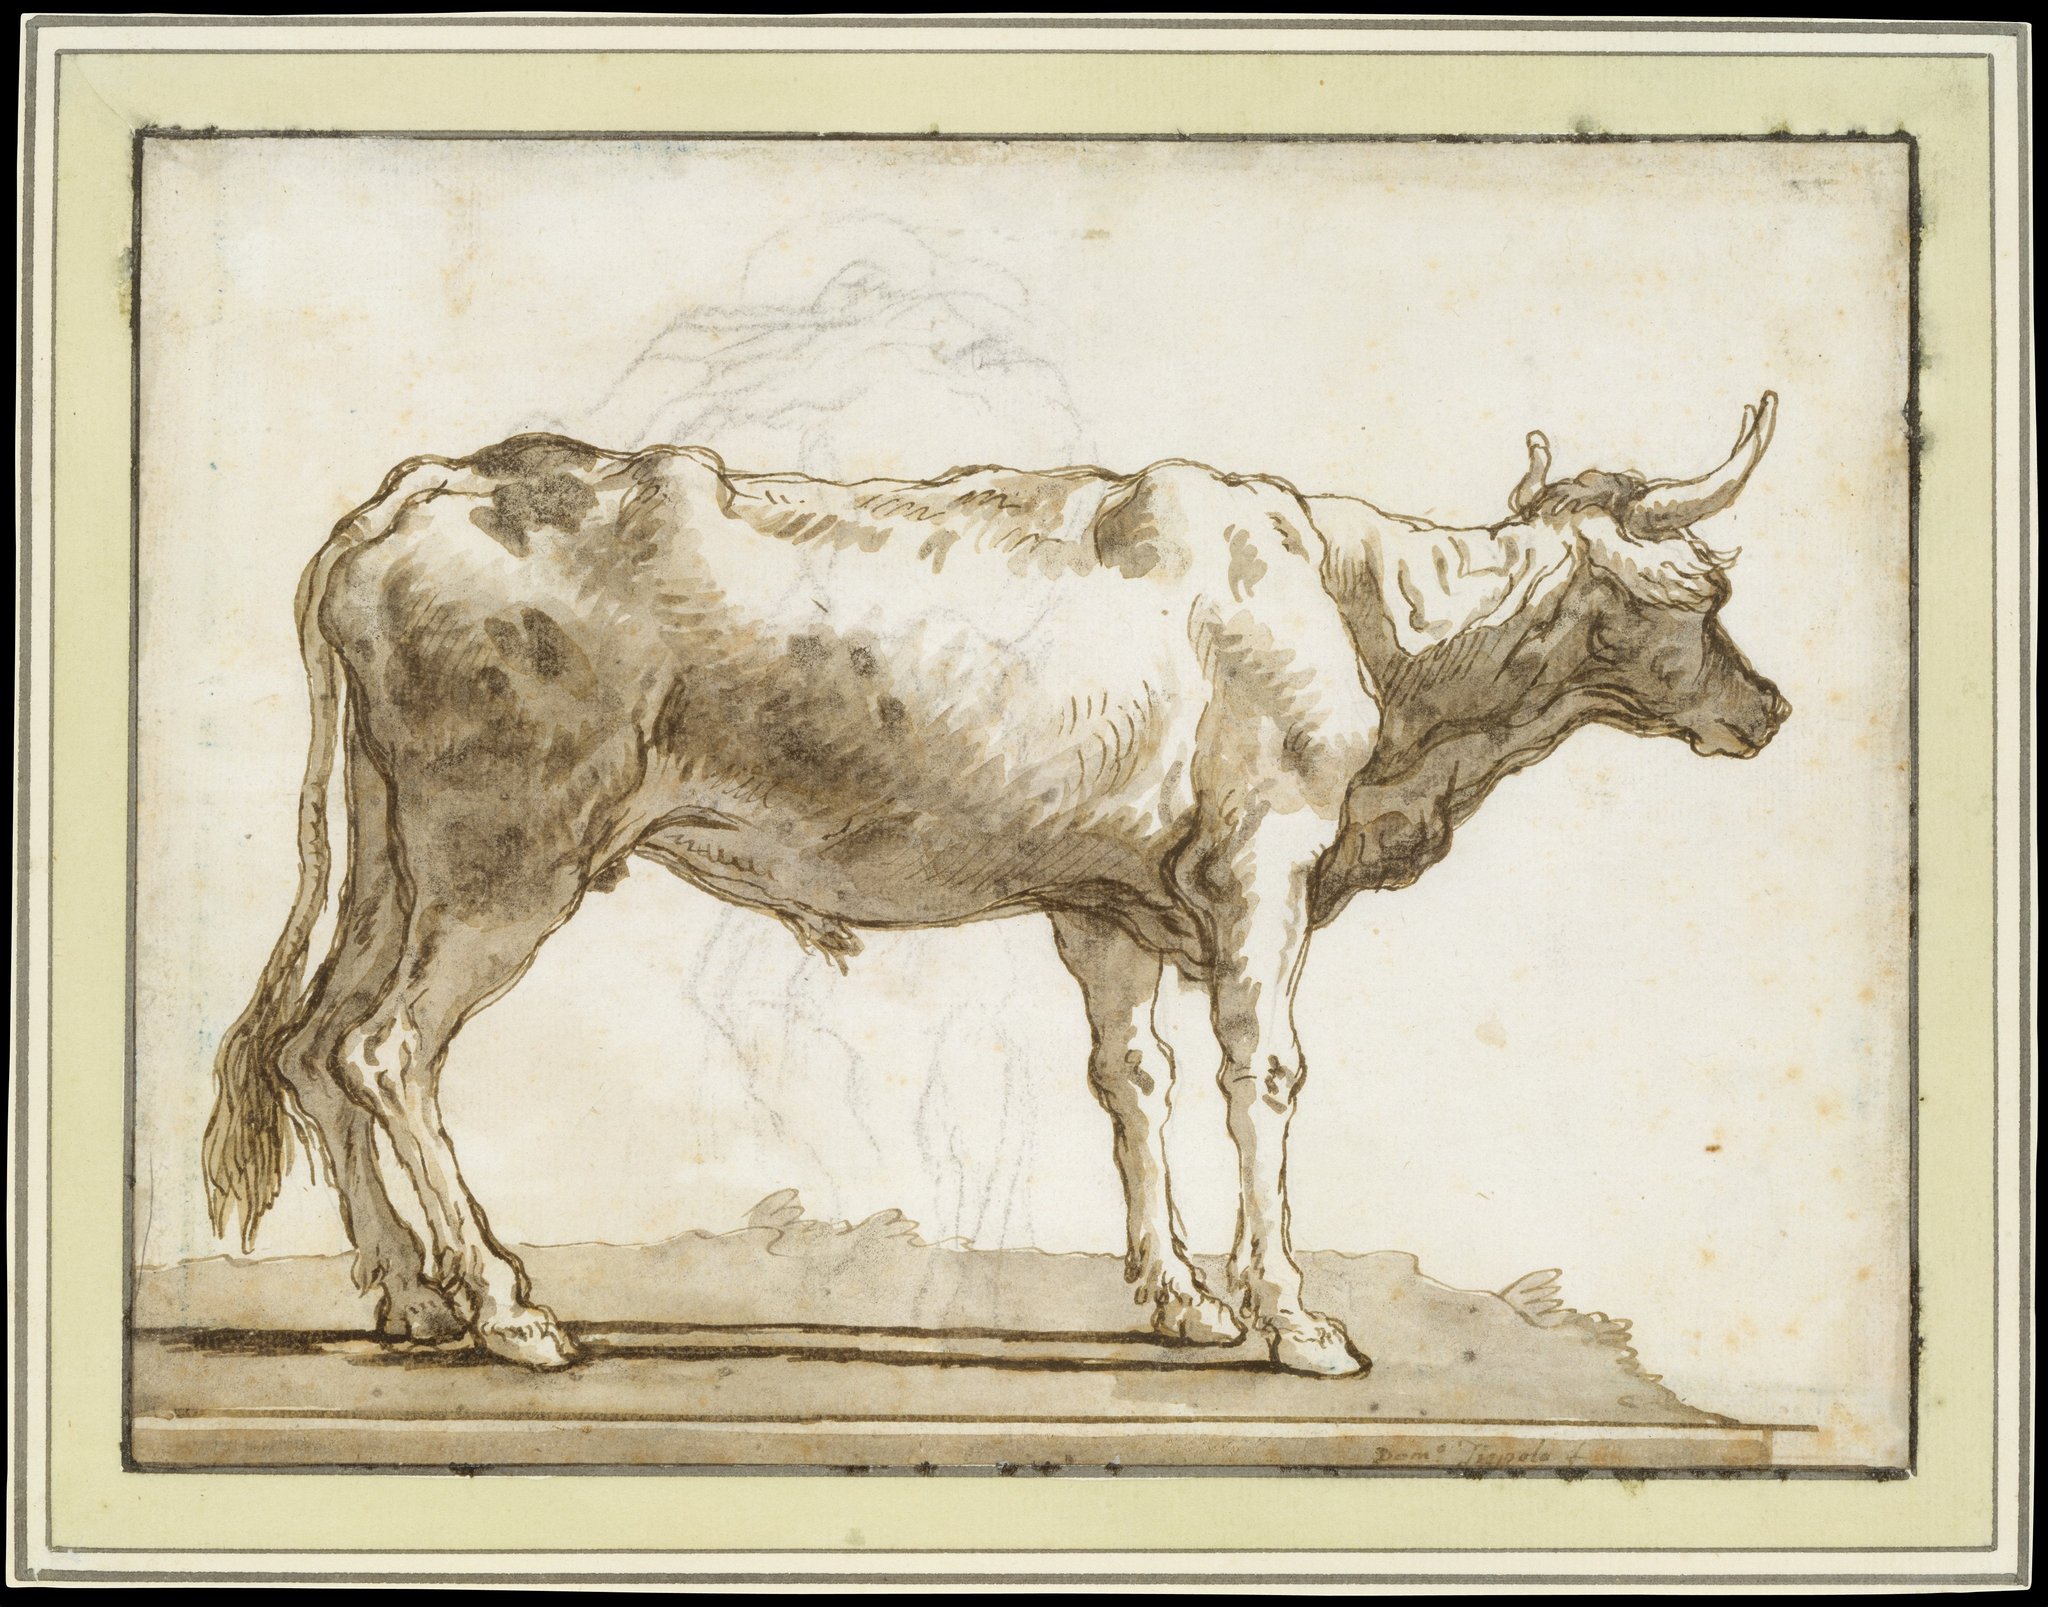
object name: drawing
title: A Bullock Standing to the Right (on a Base)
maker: giovanni domenico tiepolo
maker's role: artist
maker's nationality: italian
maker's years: 1727-1804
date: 1760-1761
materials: chalk, ink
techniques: pen, wash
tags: bulls